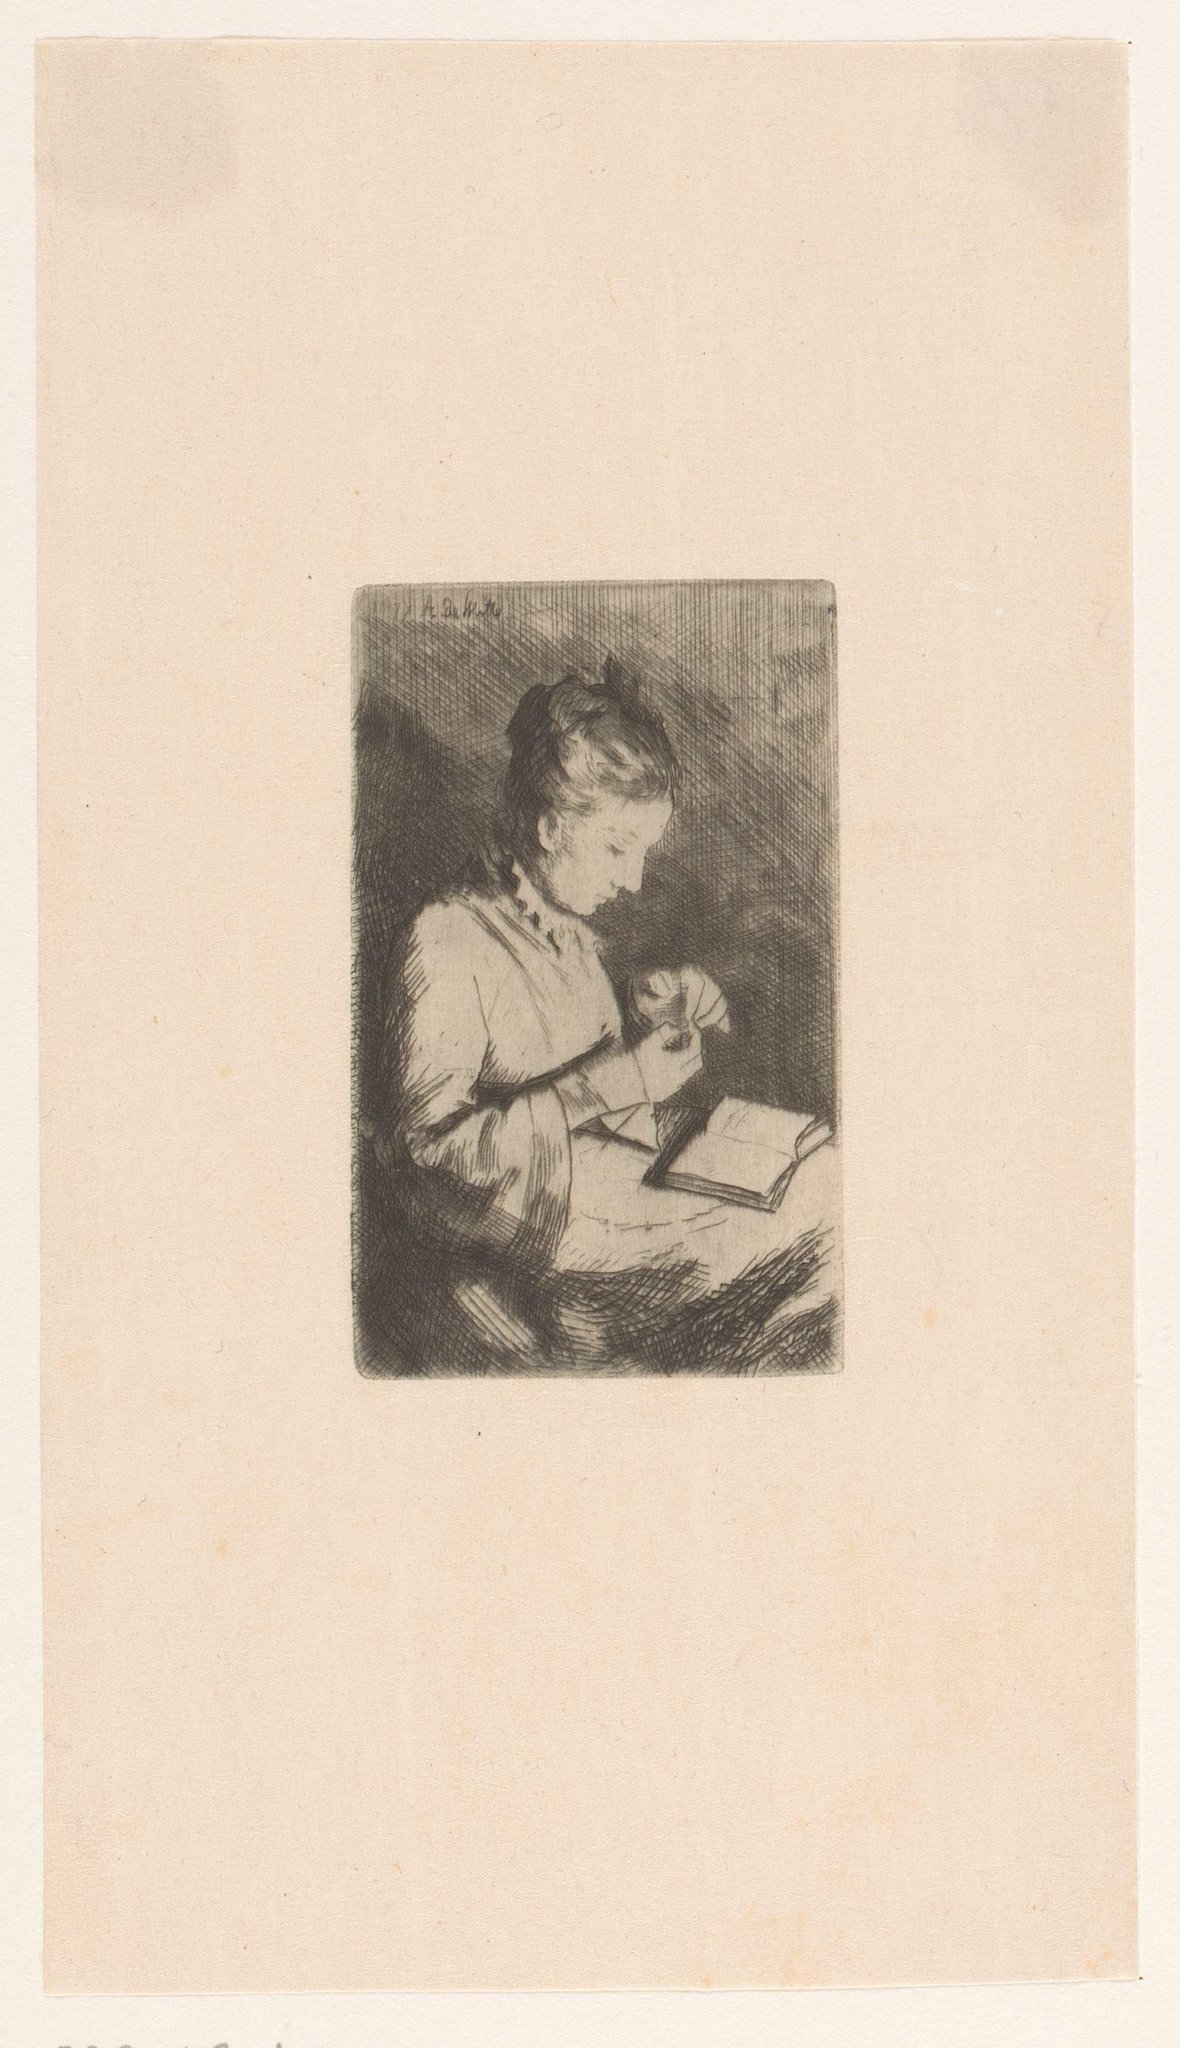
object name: print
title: Vrouw met boek op schoot en naald in haar handen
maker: adrien de witte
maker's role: print maker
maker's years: 1850-1935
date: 1877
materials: paper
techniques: etching, retroussage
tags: adult woman, reading, book - mm - book open, needle ~ sewing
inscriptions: collector's mark: Lugt 2228